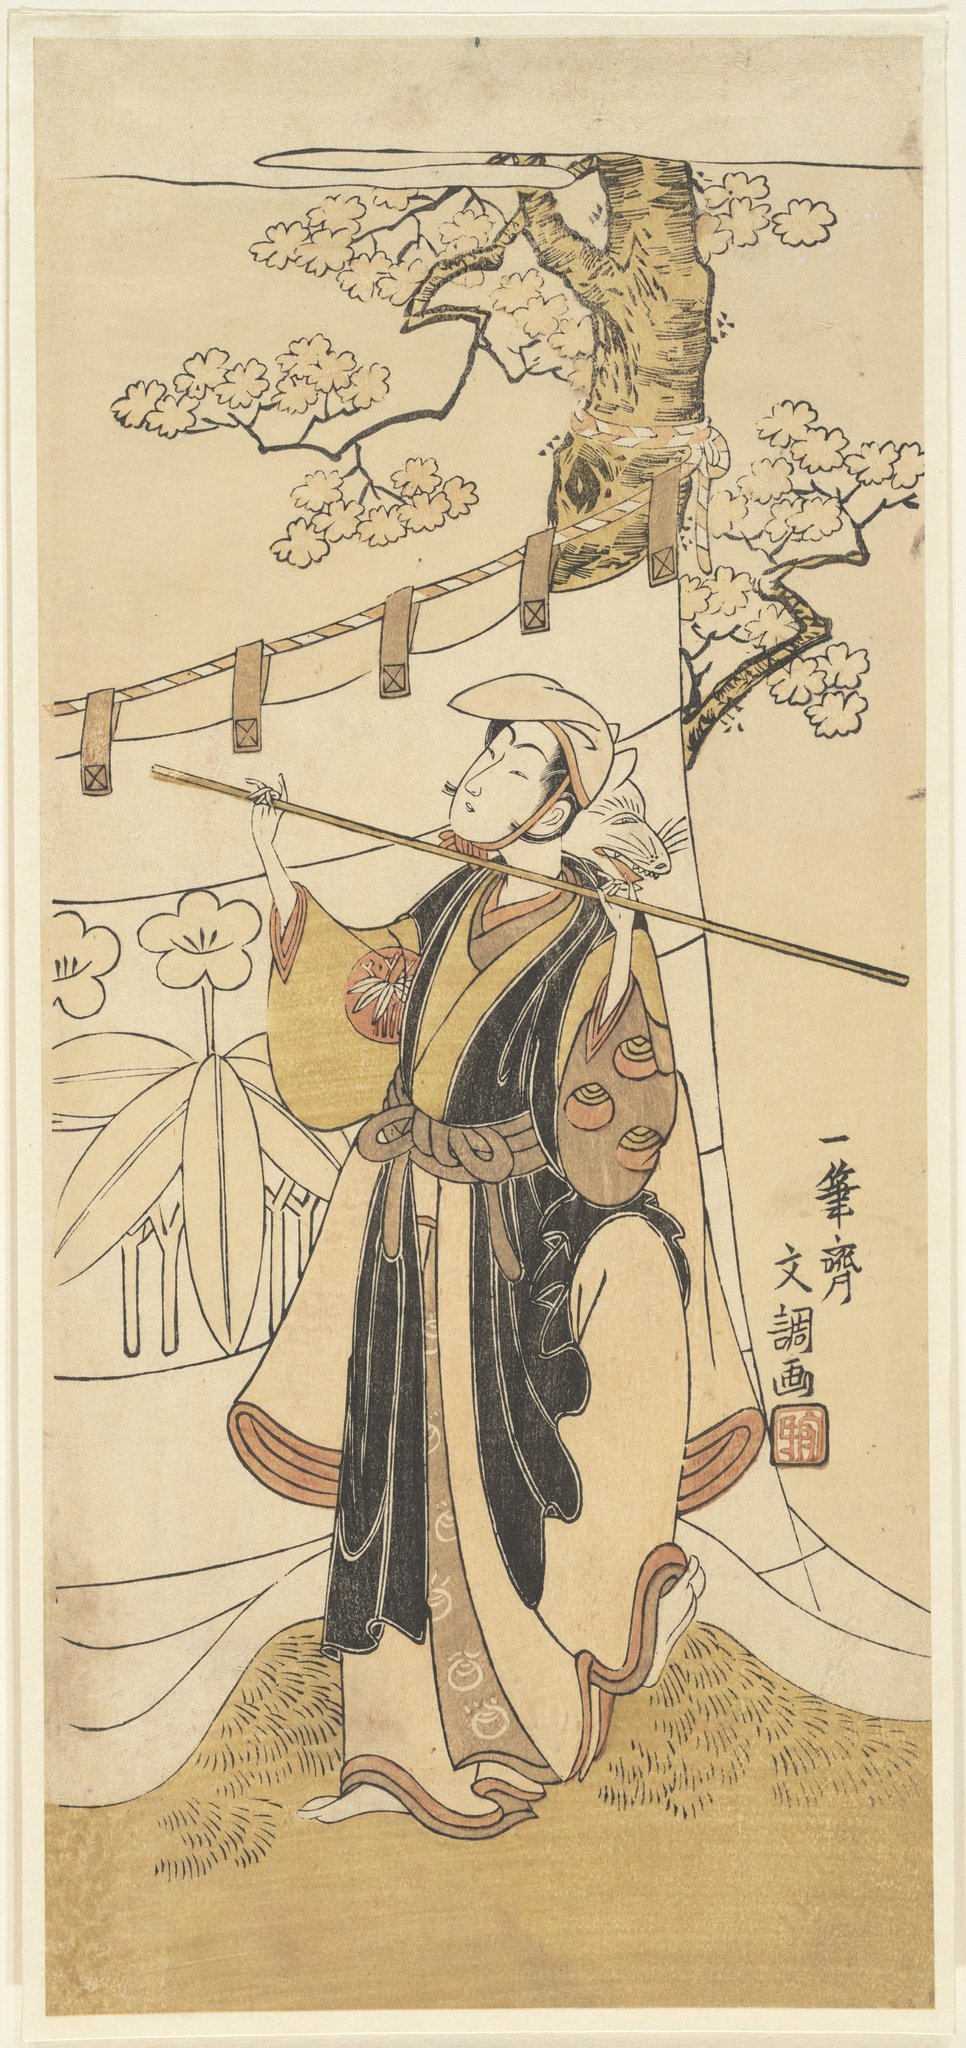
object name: print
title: The Actor Yamashita Kyonosuke in the Role of Tamarimaru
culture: japanese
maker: ippitsusai bunchō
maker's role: artist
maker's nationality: japanese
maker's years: 1765-1792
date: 1769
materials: ink, paper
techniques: woodblock print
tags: men,trees,actors